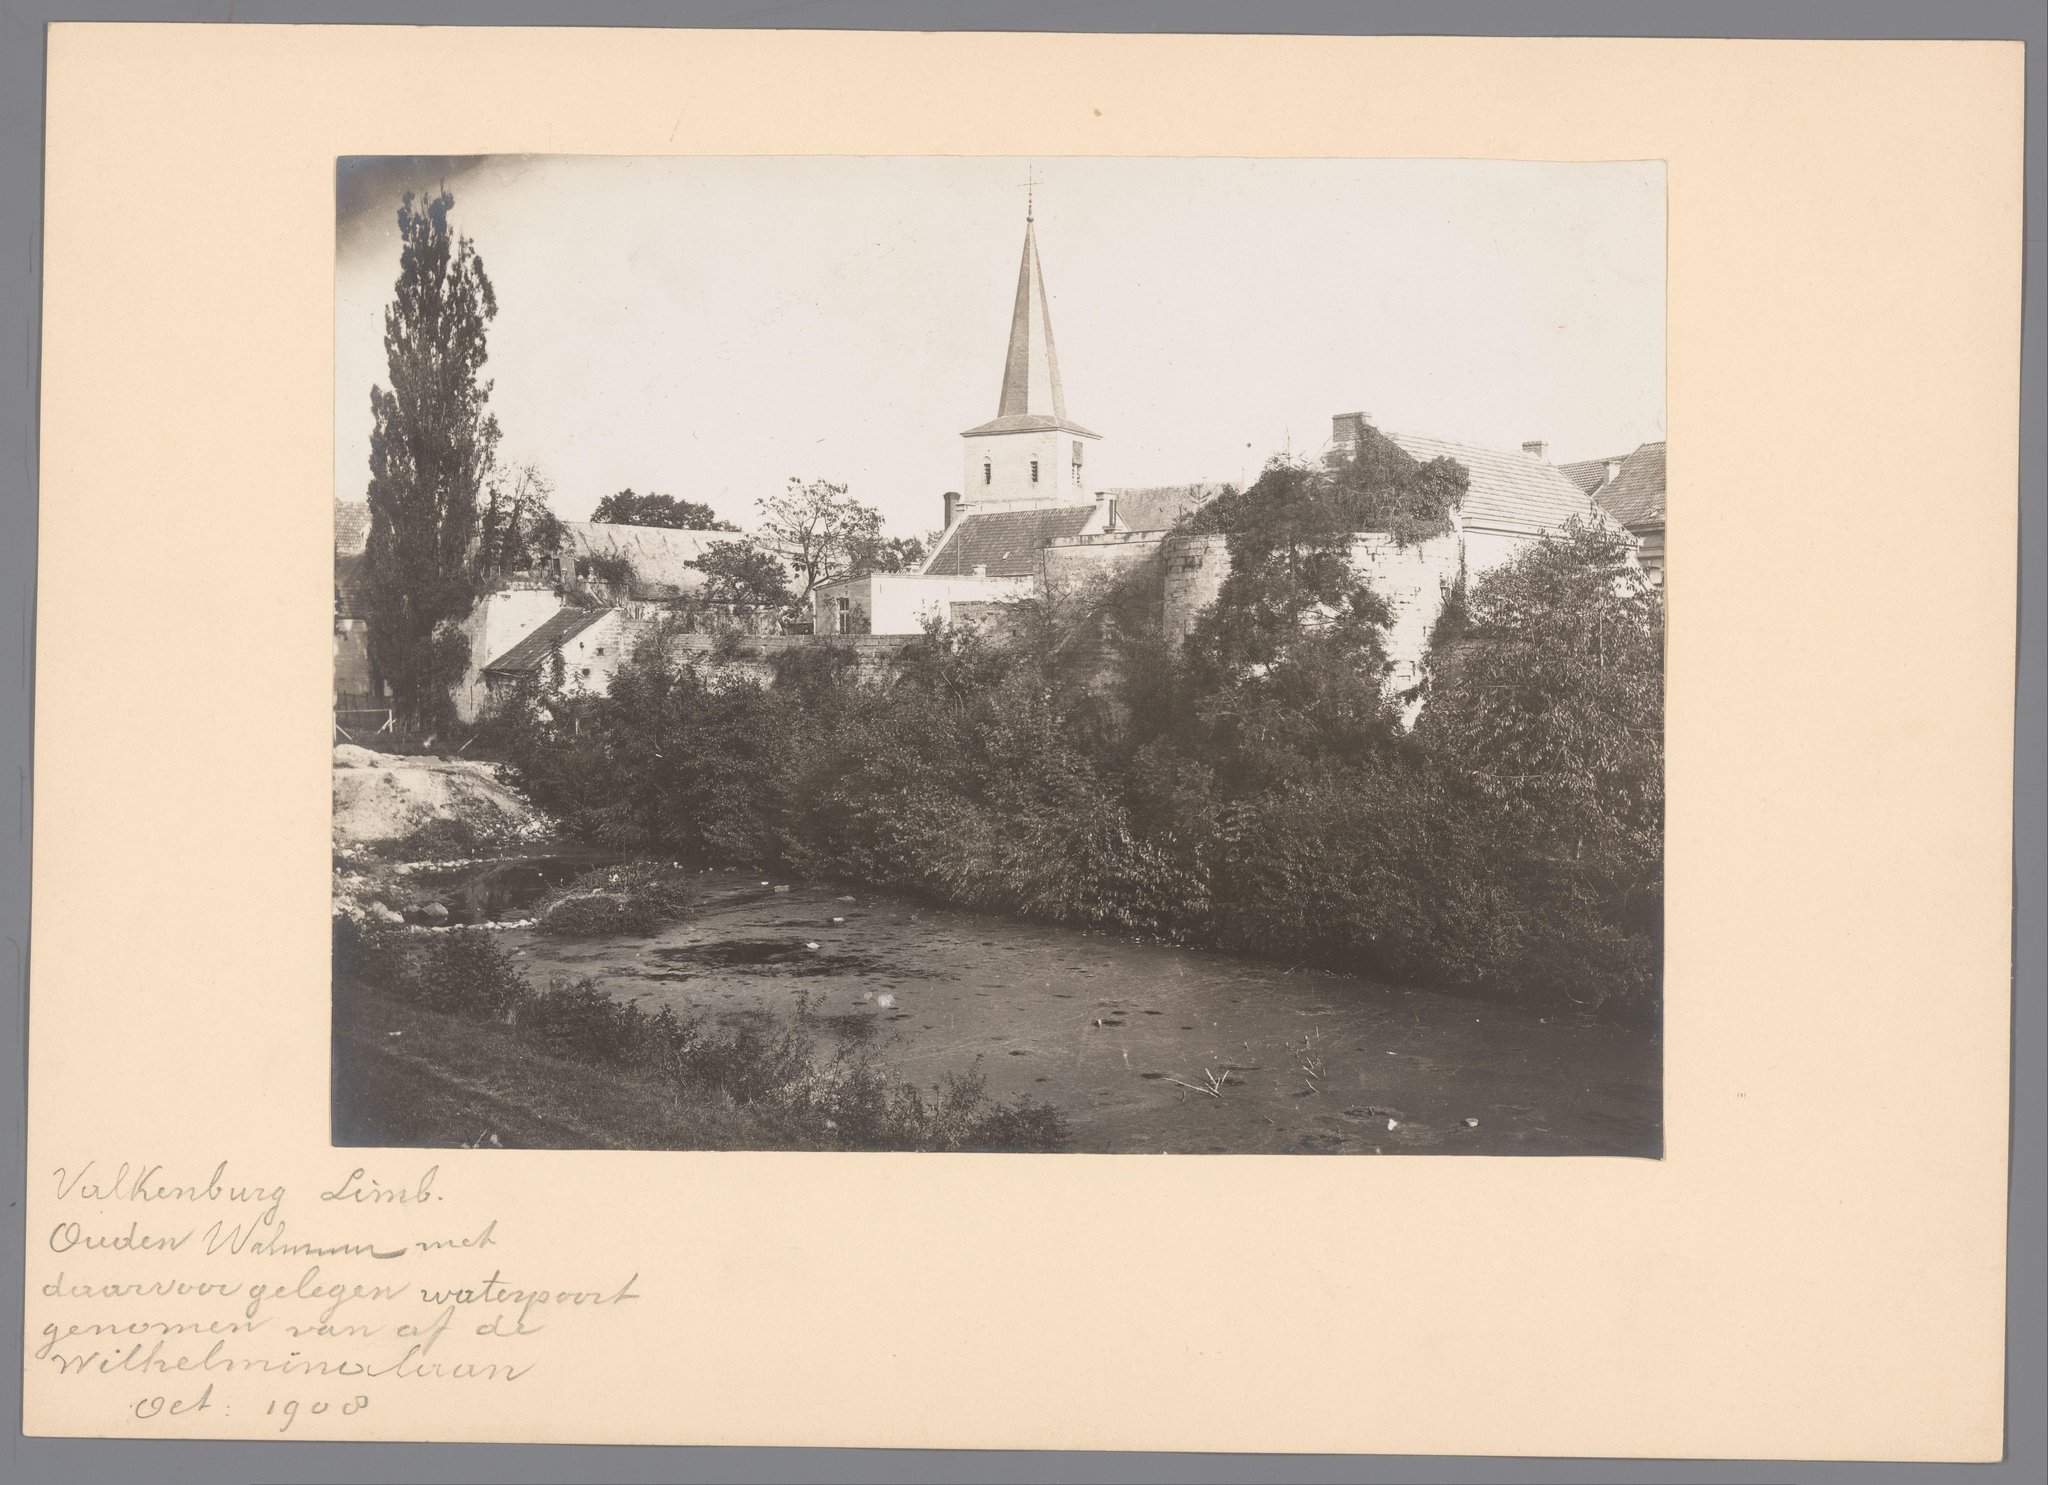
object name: photograph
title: Gezicht op de stadsmuur met kerk te Valkenburg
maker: anoniem (monumentenzorg)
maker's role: fotograaf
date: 1908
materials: cardboard, photographic support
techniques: gelatin silver print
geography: valkenburg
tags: church (exterior), walls ~ fortified city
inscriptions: annotation: ‘Topografie/ Valkenburg’, annotation: ‘Valkenburg limb./ Ouden Walmuur met daarvoor gelegen waterpoort genomen van af de Wilhelminalaan/ oct: 1908’